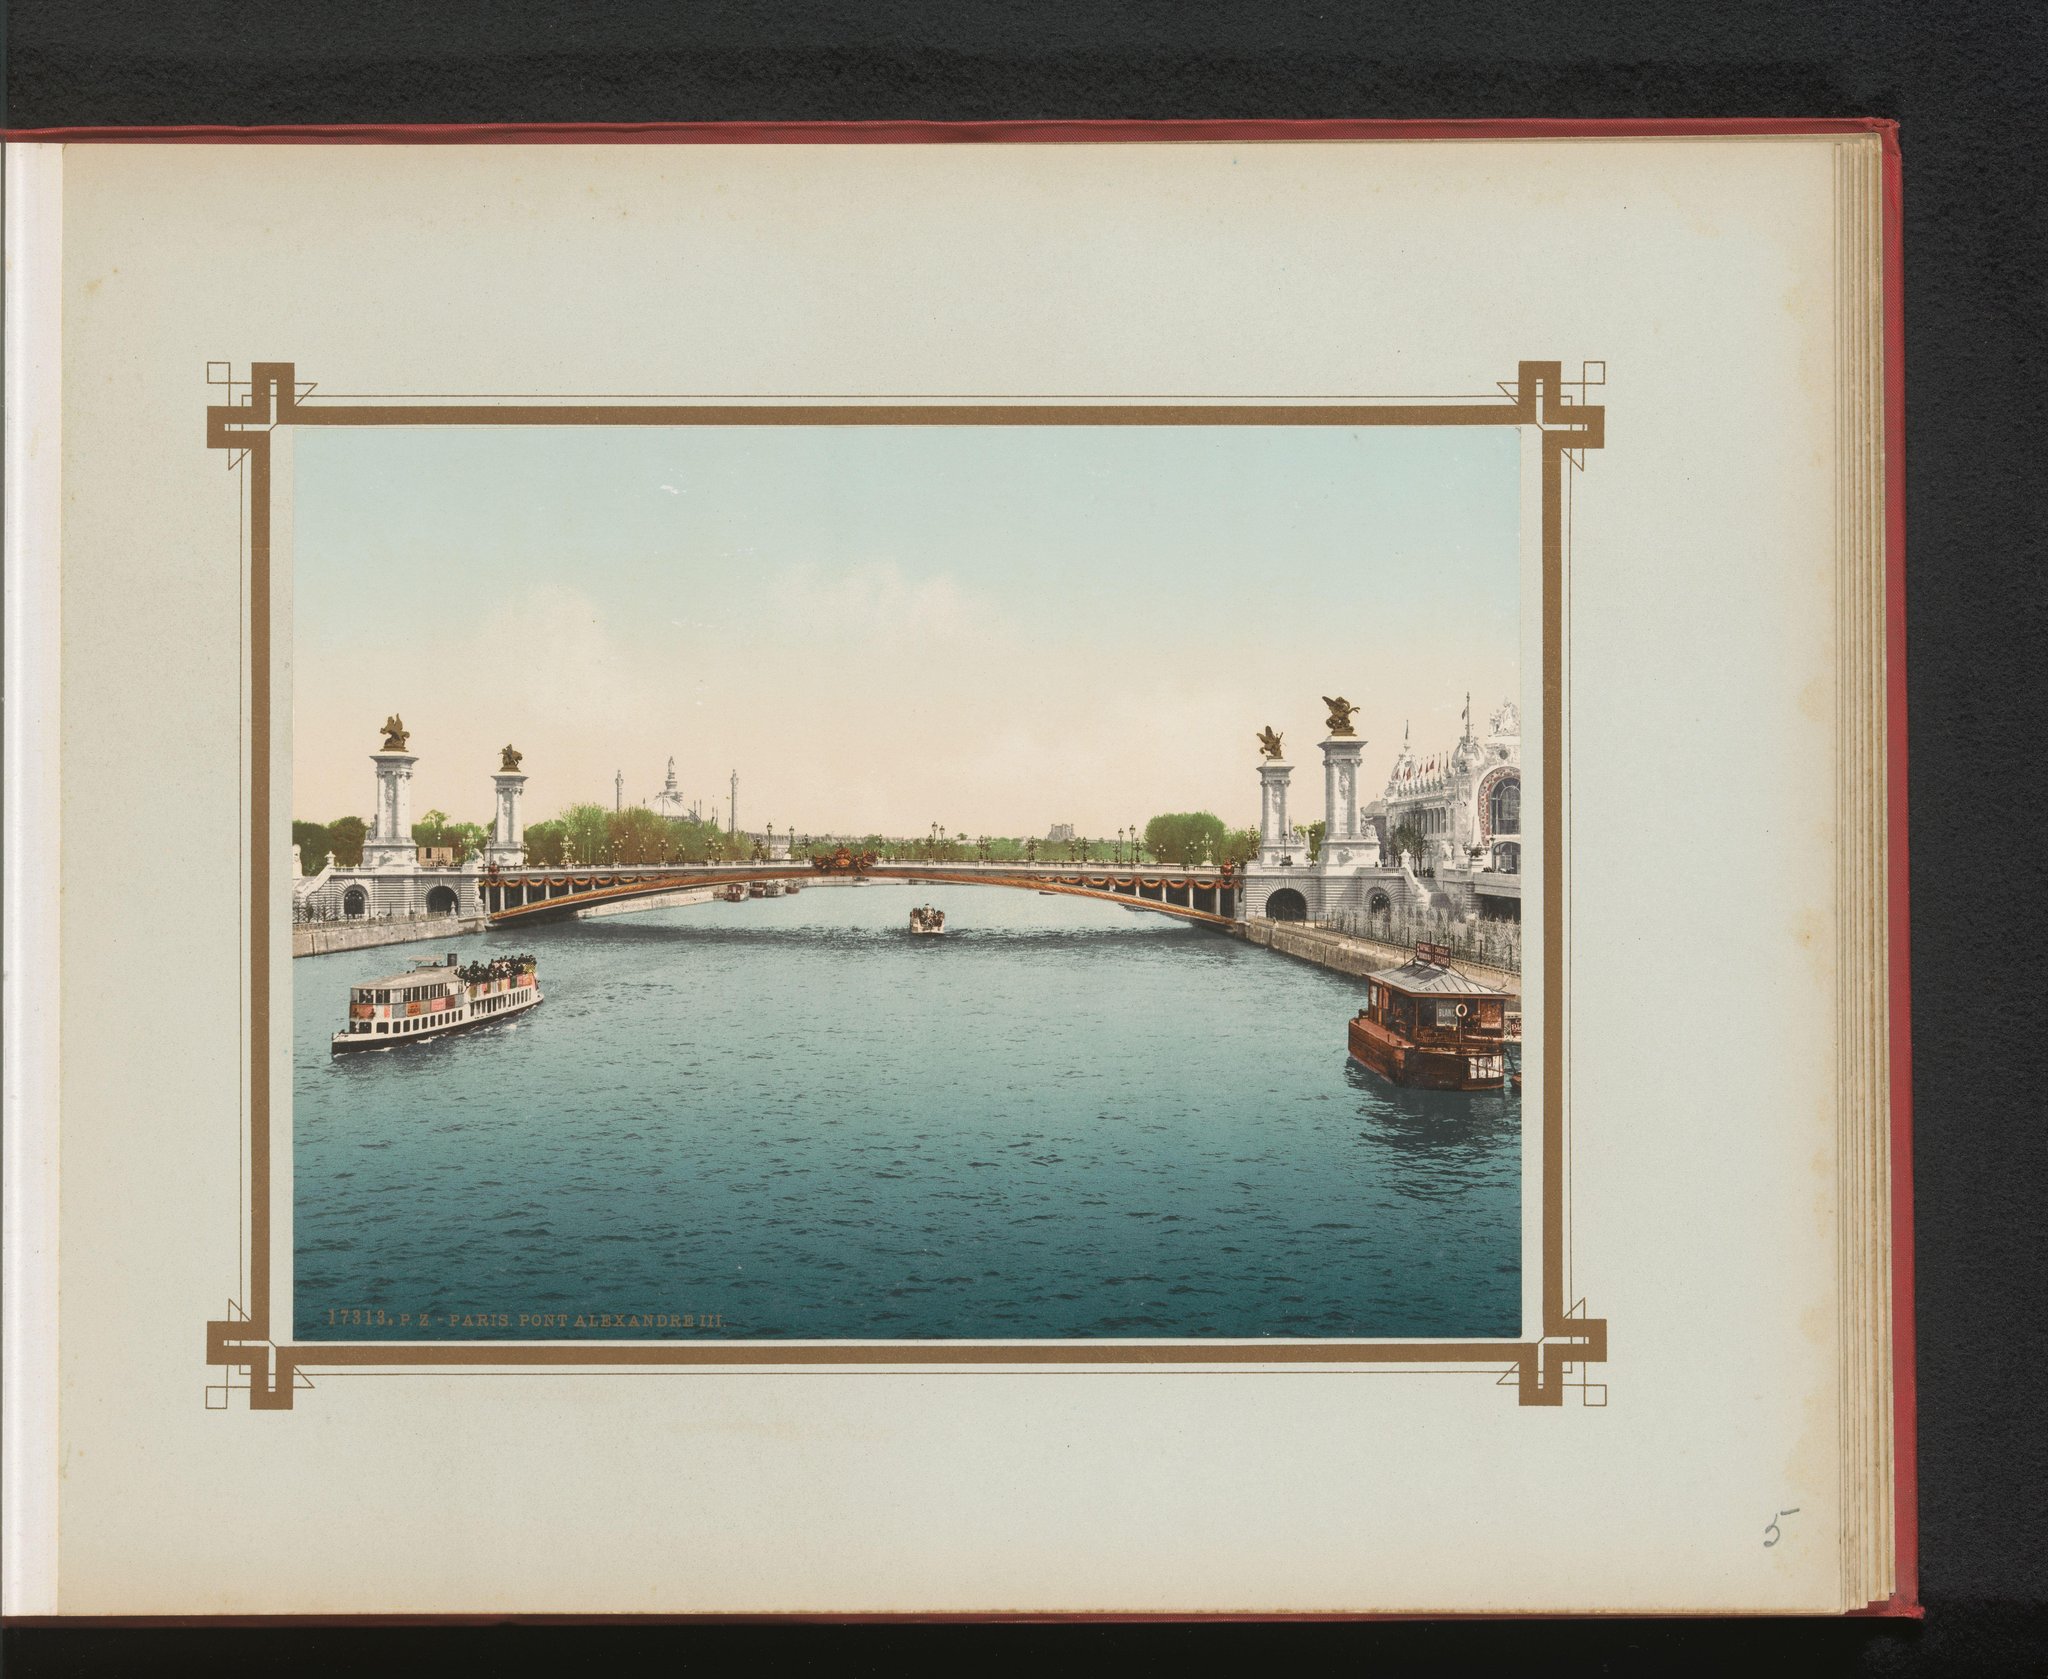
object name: photomechanical print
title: Gezicht op Pont Alexandre-III tijdens de Wereldtentoonstelling van 1900 te Parijs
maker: Anonymous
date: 1900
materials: paper, photographic process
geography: paris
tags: world fair, world exhibition, avenue, boulevard, promenade, esplanade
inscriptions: inscription: ‘17313. P.Z. Paris, Pont Alexandre III’